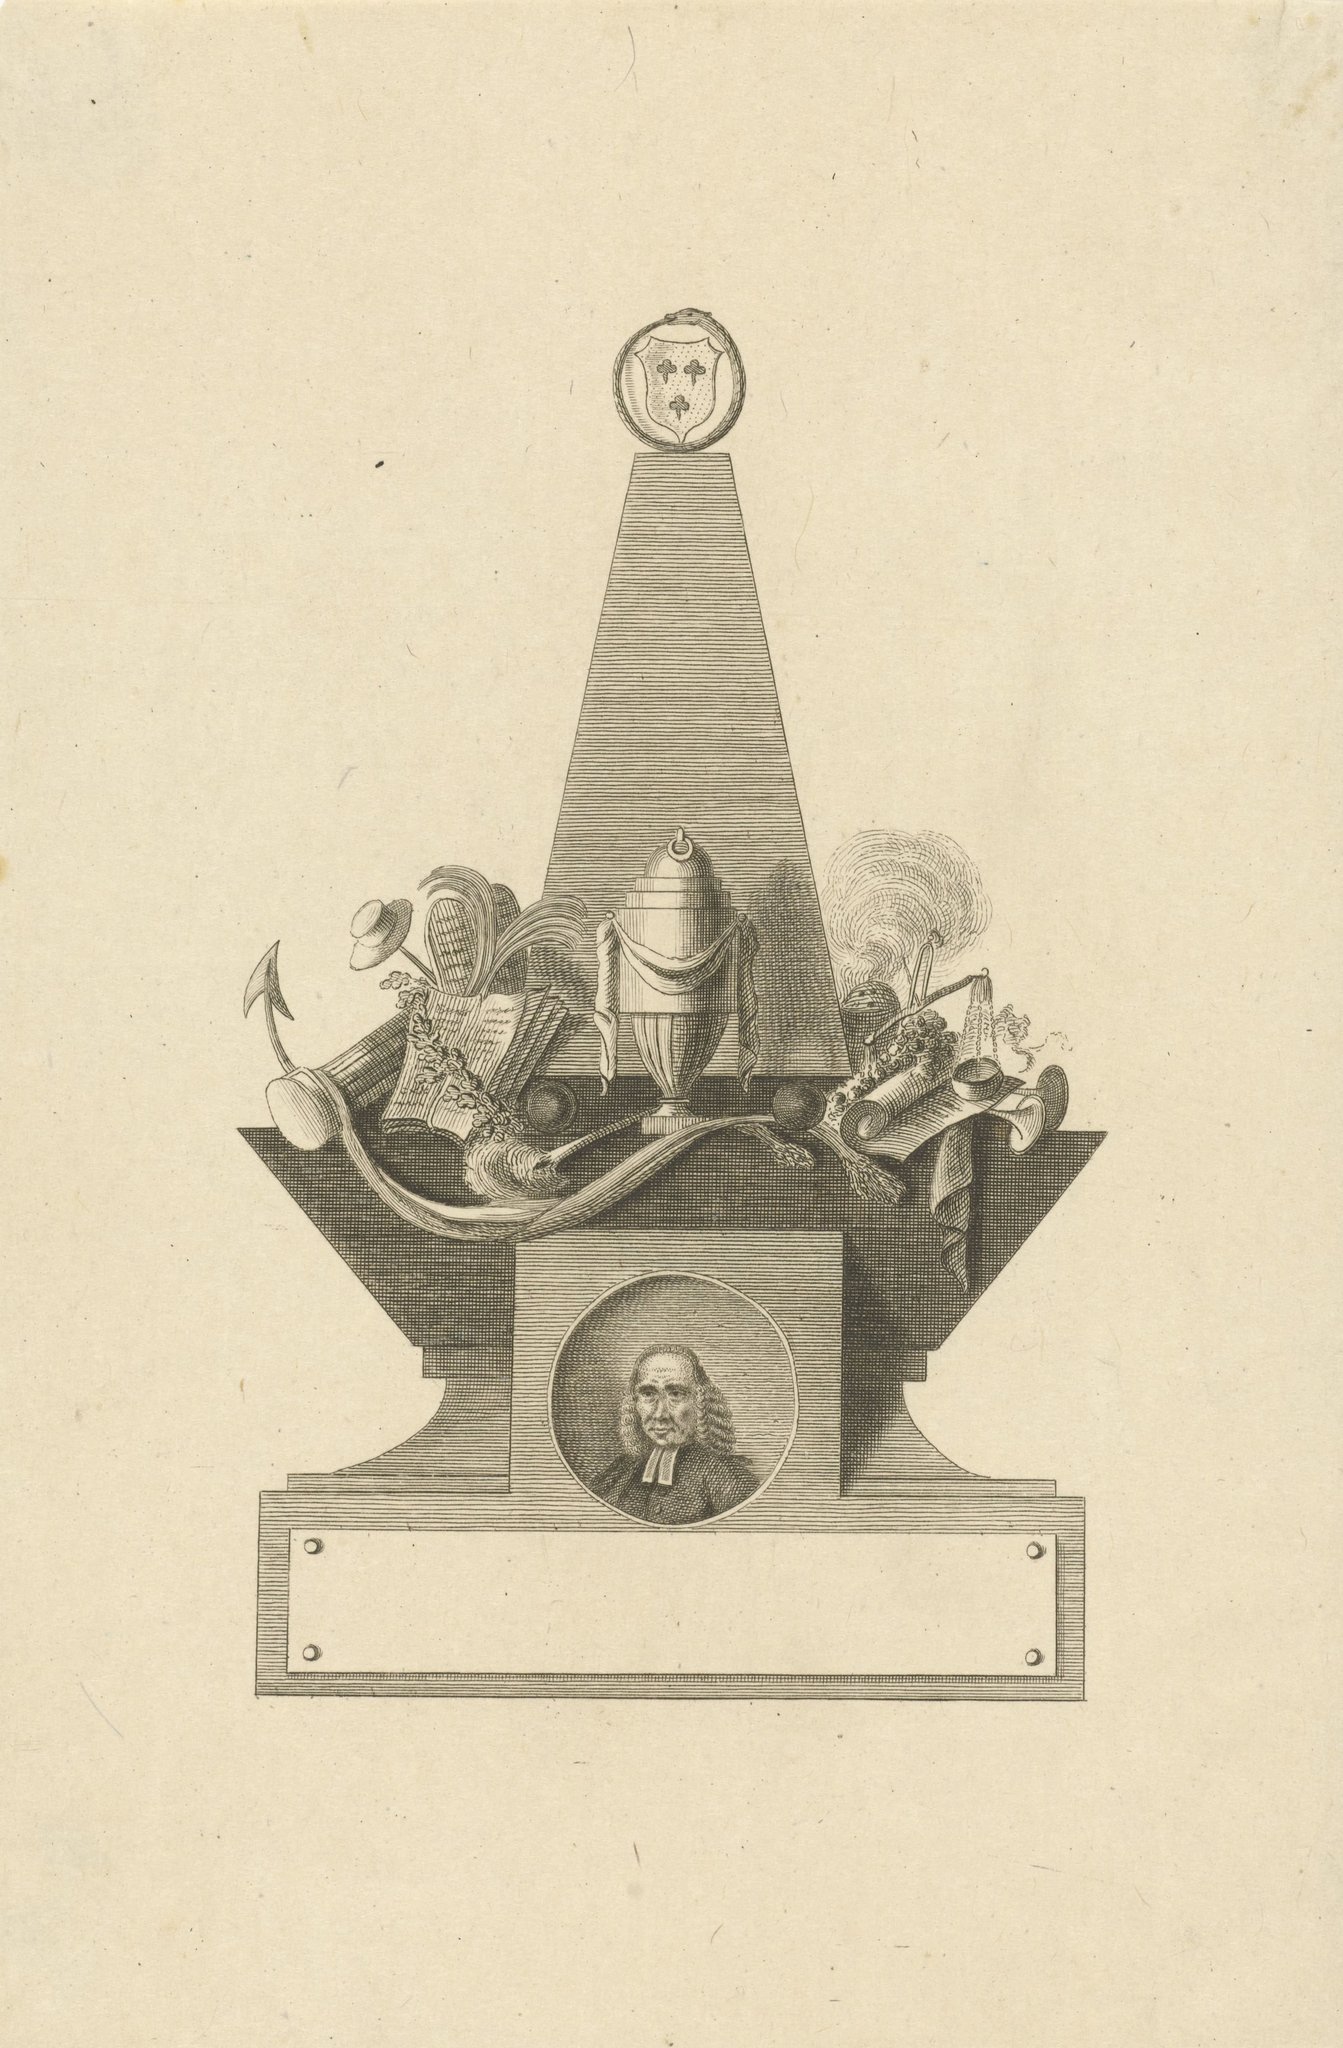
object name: print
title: Gedenkteken voor Gualtherus Zoutmaat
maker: pieter de mare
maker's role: print maker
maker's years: 1758-1796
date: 1793-1796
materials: paper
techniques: engraving, etching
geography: leiden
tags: grave, tomb and other grave-forms and grave-markers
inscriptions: collector's mark: Lugt 2228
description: Gedenkteken voor de predikant Gualtherus Zoutmaat.